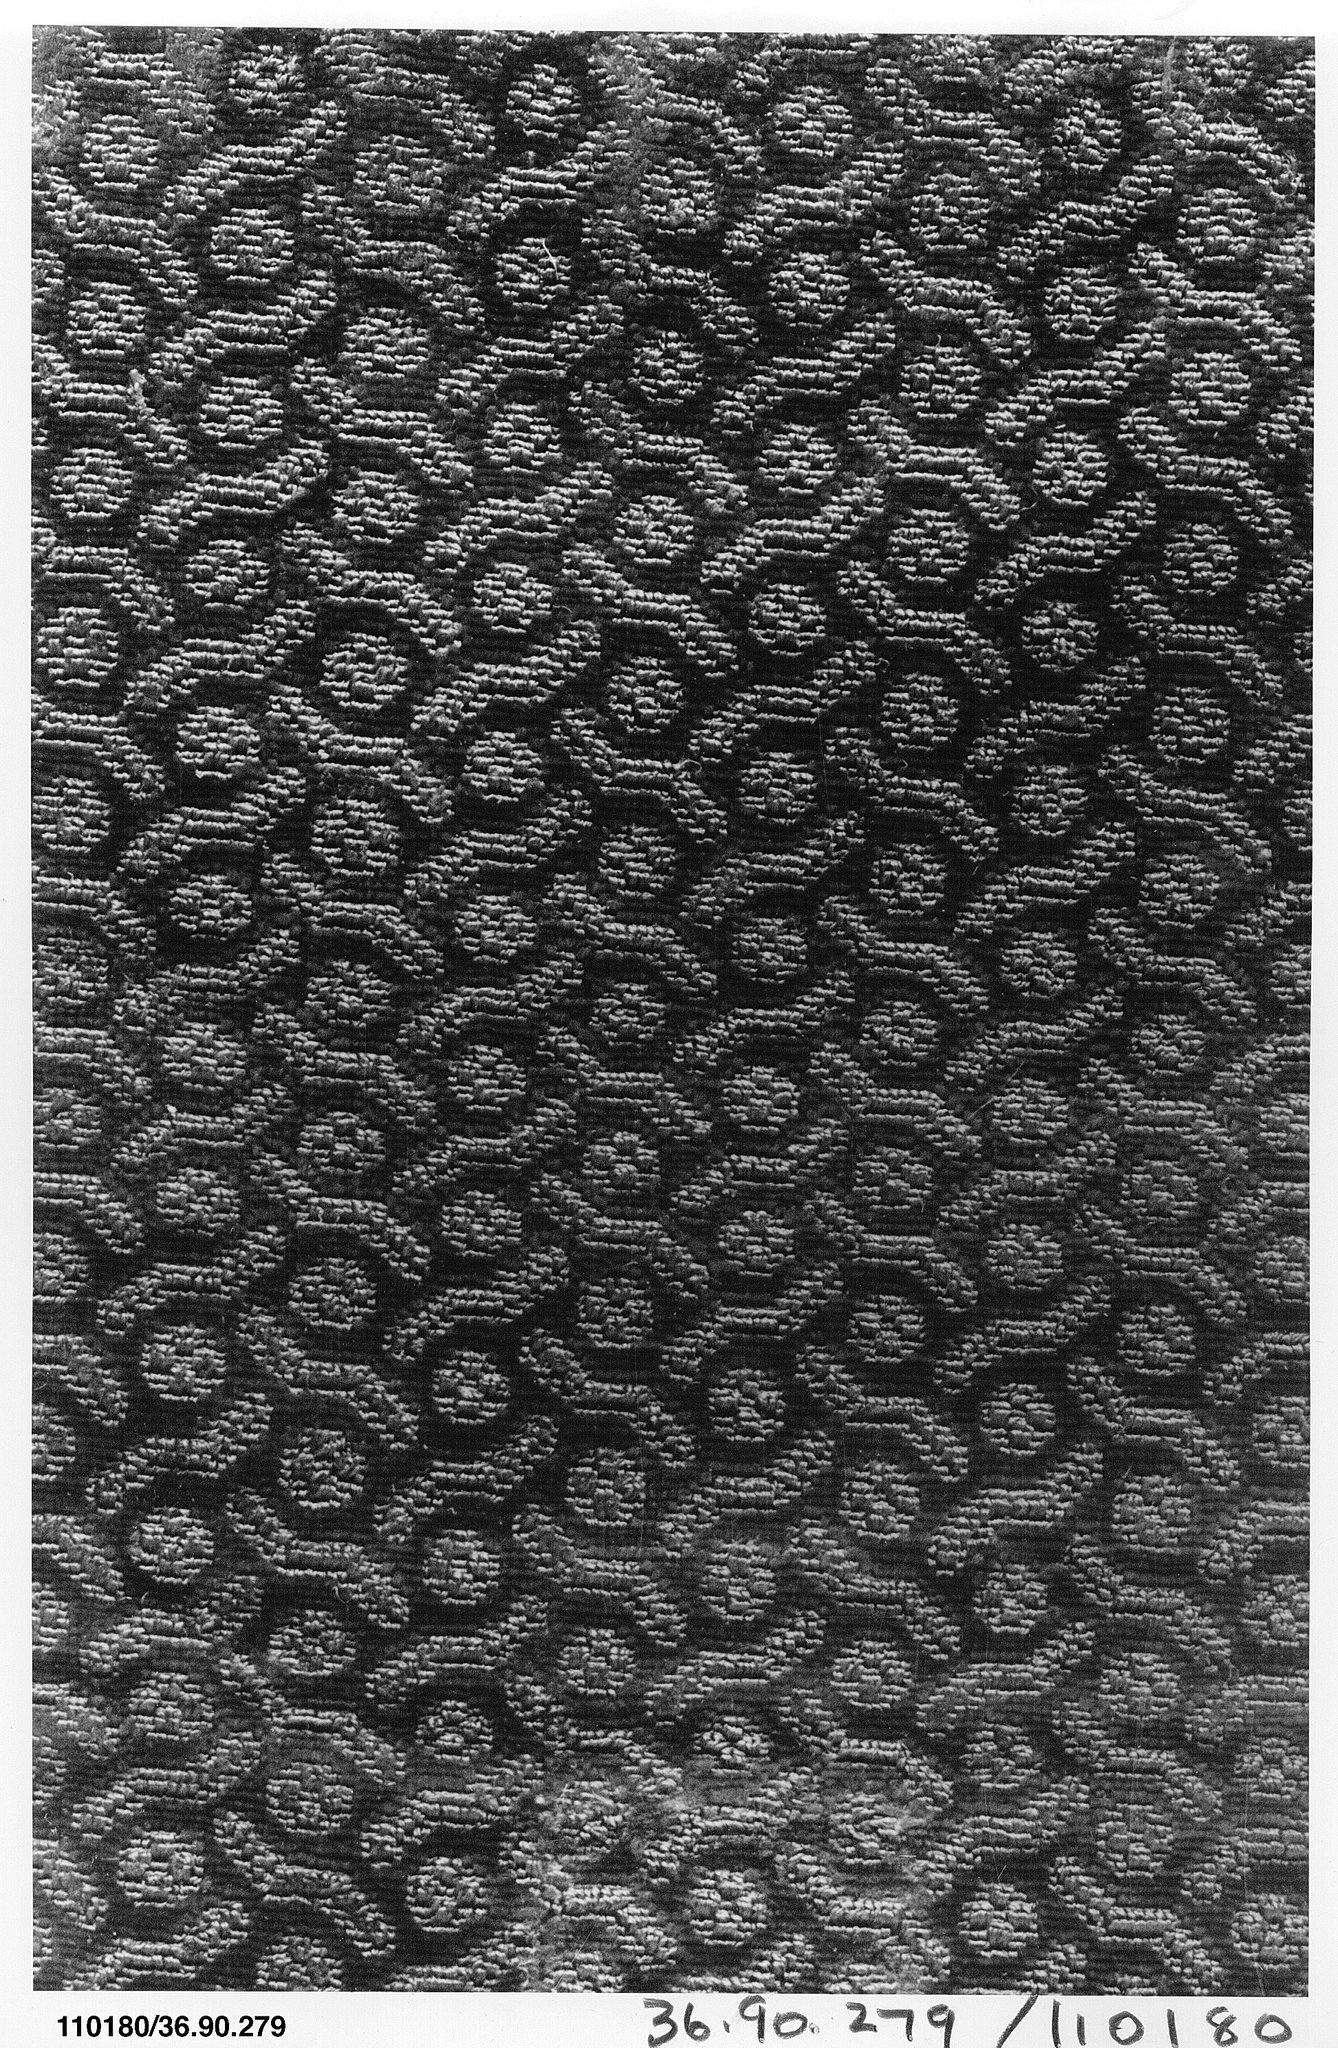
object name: piece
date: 1501-1700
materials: silk